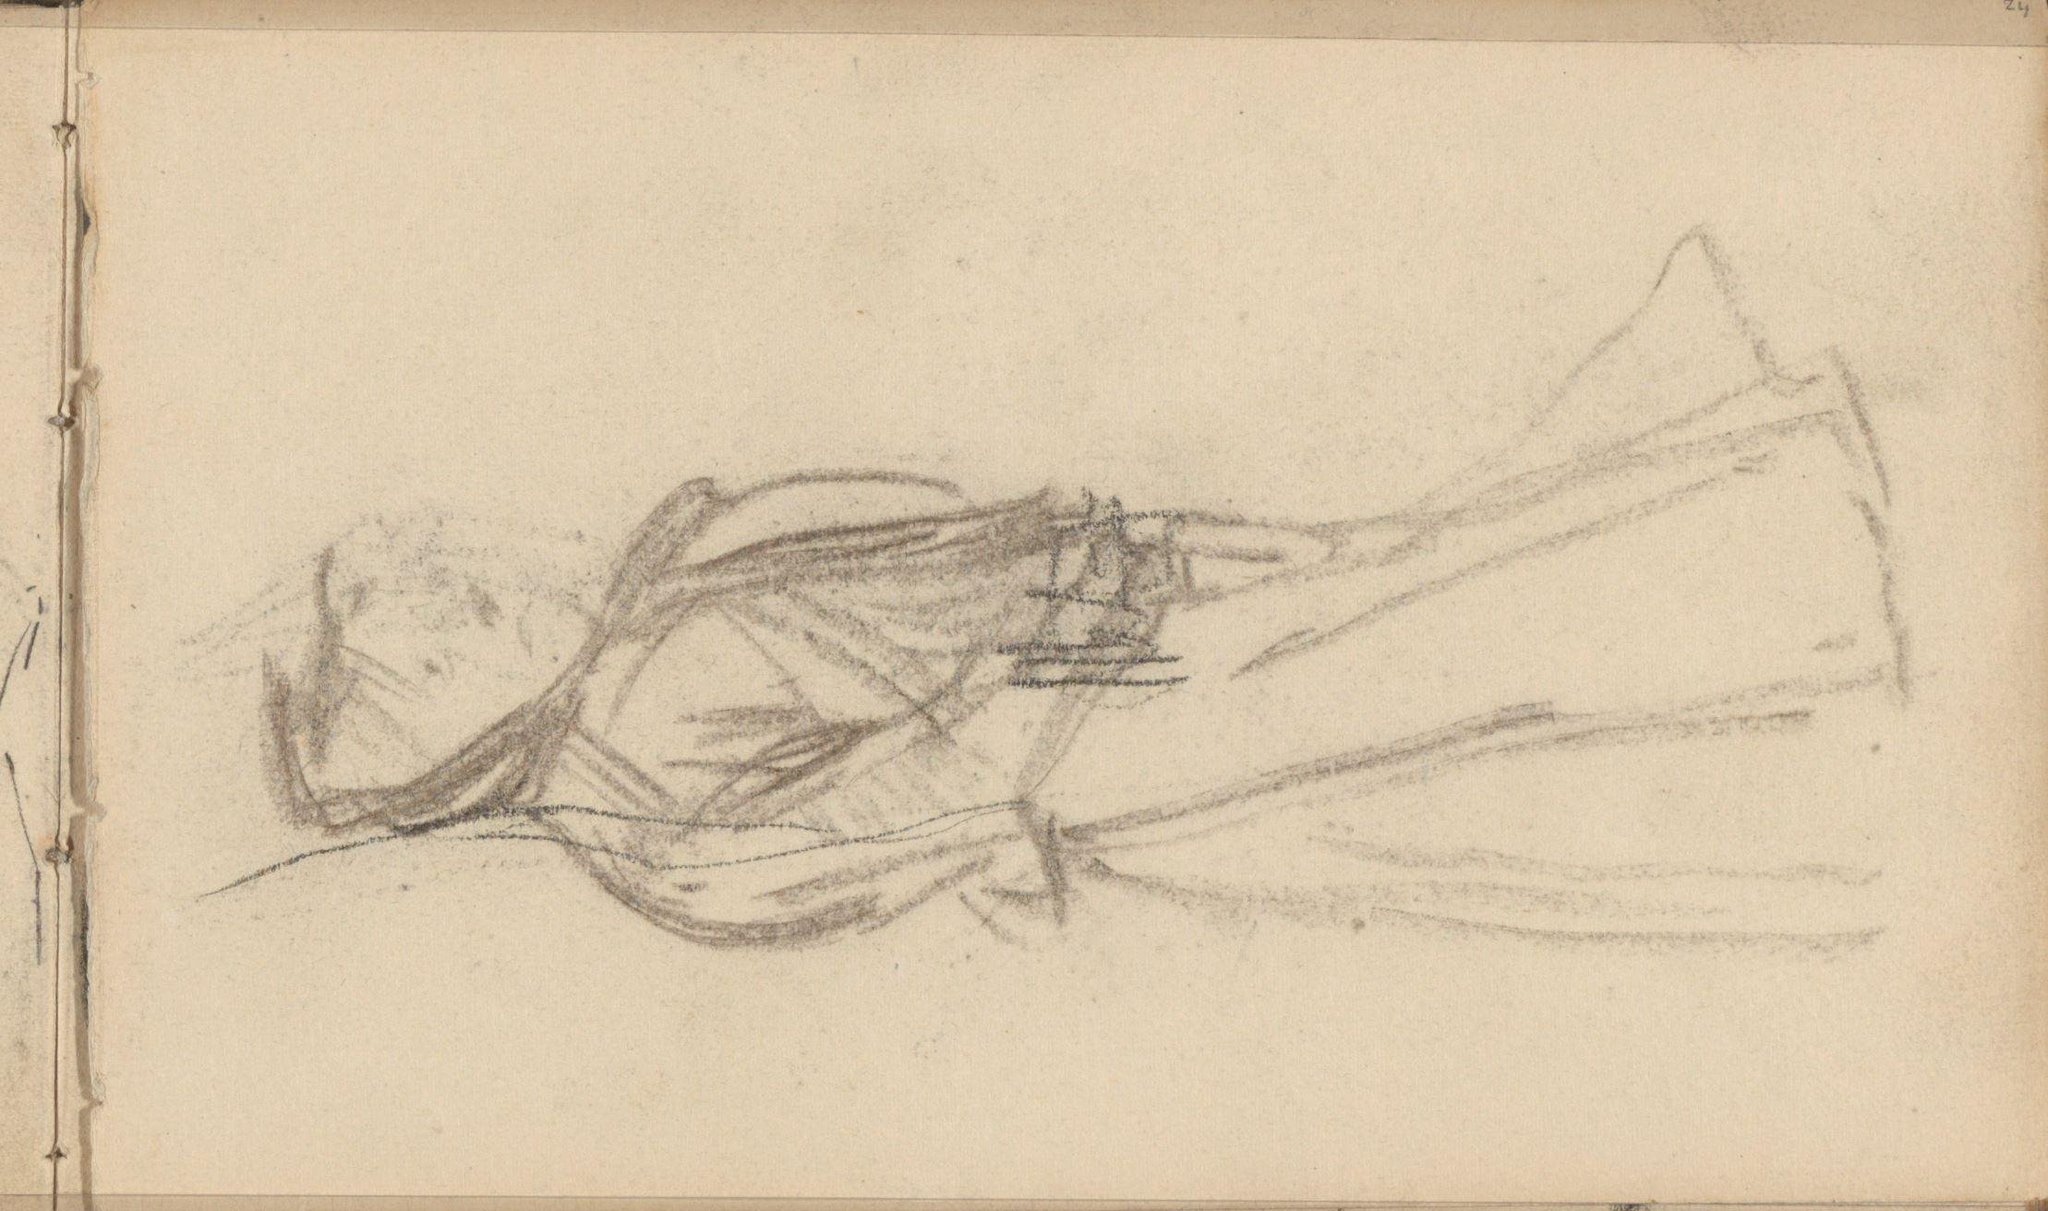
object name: sketchbook leaf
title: Staande vrouw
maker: george hendrik breitner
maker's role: draughtsman, painter, print maker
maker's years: 1857-1923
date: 1884-1886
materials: chalk, paper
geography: the hague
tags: adult woman, standing figure - aa - female human figure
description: Pagina 24 uit een schetsboek met 35 bladen.